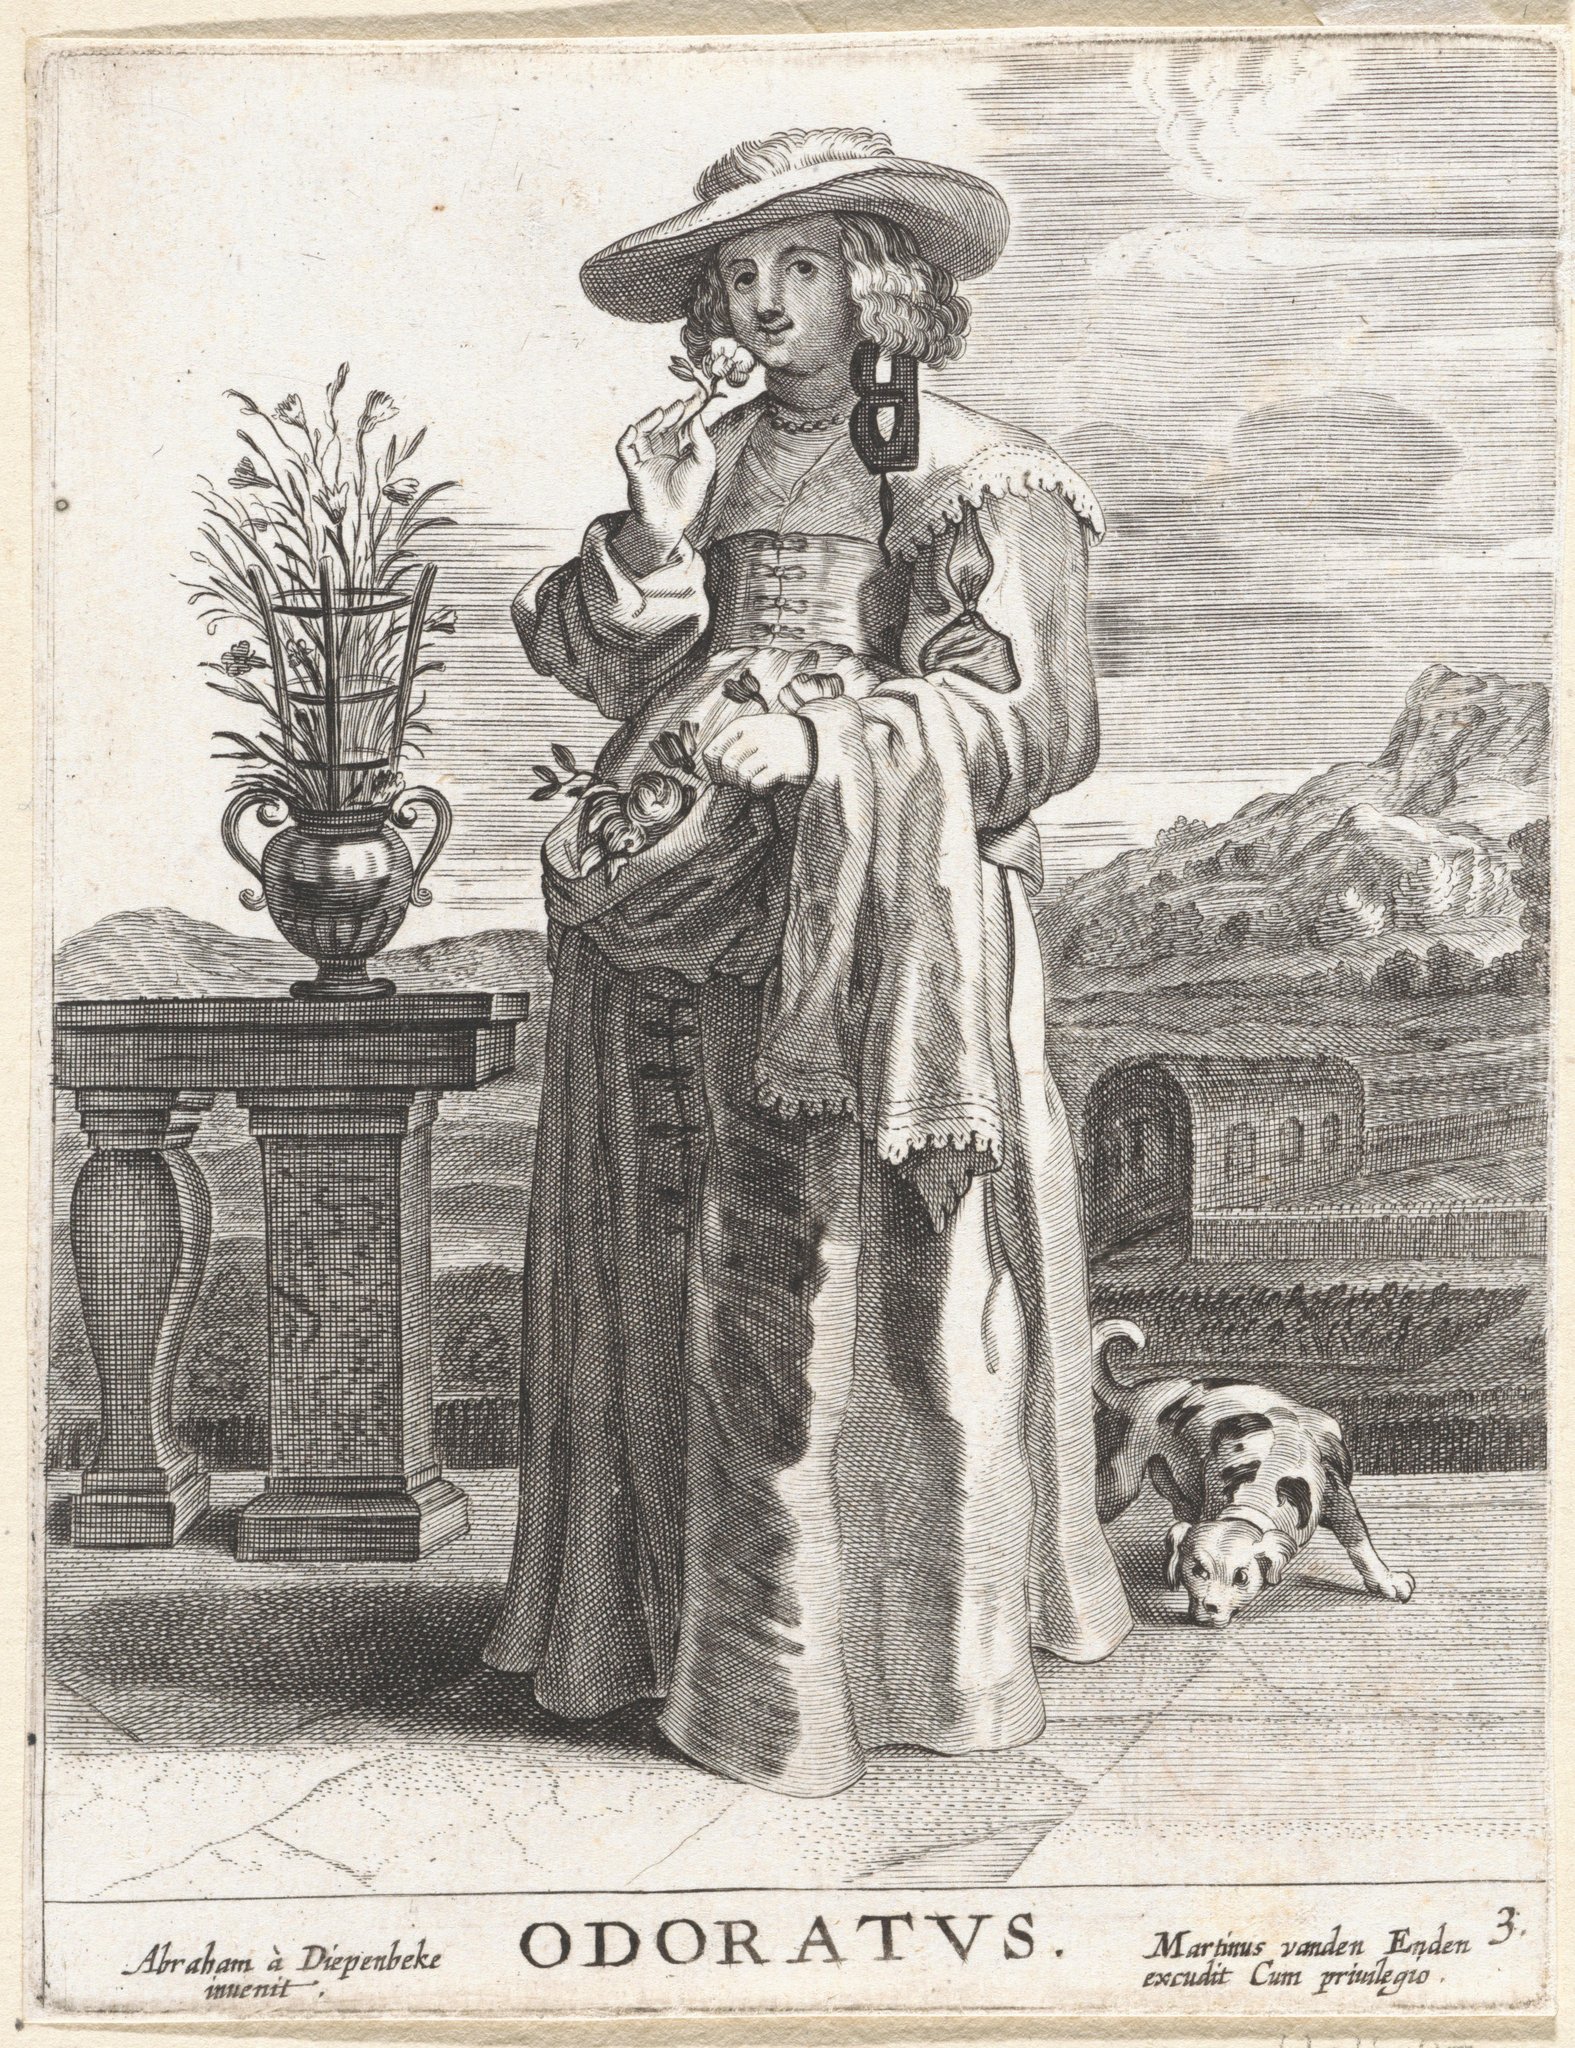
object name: print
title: Reuk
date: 1630-1654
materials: paper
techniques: engraving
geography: southern netherlands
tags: agreeable smell - aa - female human figure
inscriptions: collector's mark: Lugt 240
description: Personificatie van het zintuig Reuk. Een vrouw ruikt aan een bloem. In haar schort liggen nog meer bloemen. Achter haar snuffelt een hond. In de verte een gezicht op een landschap.